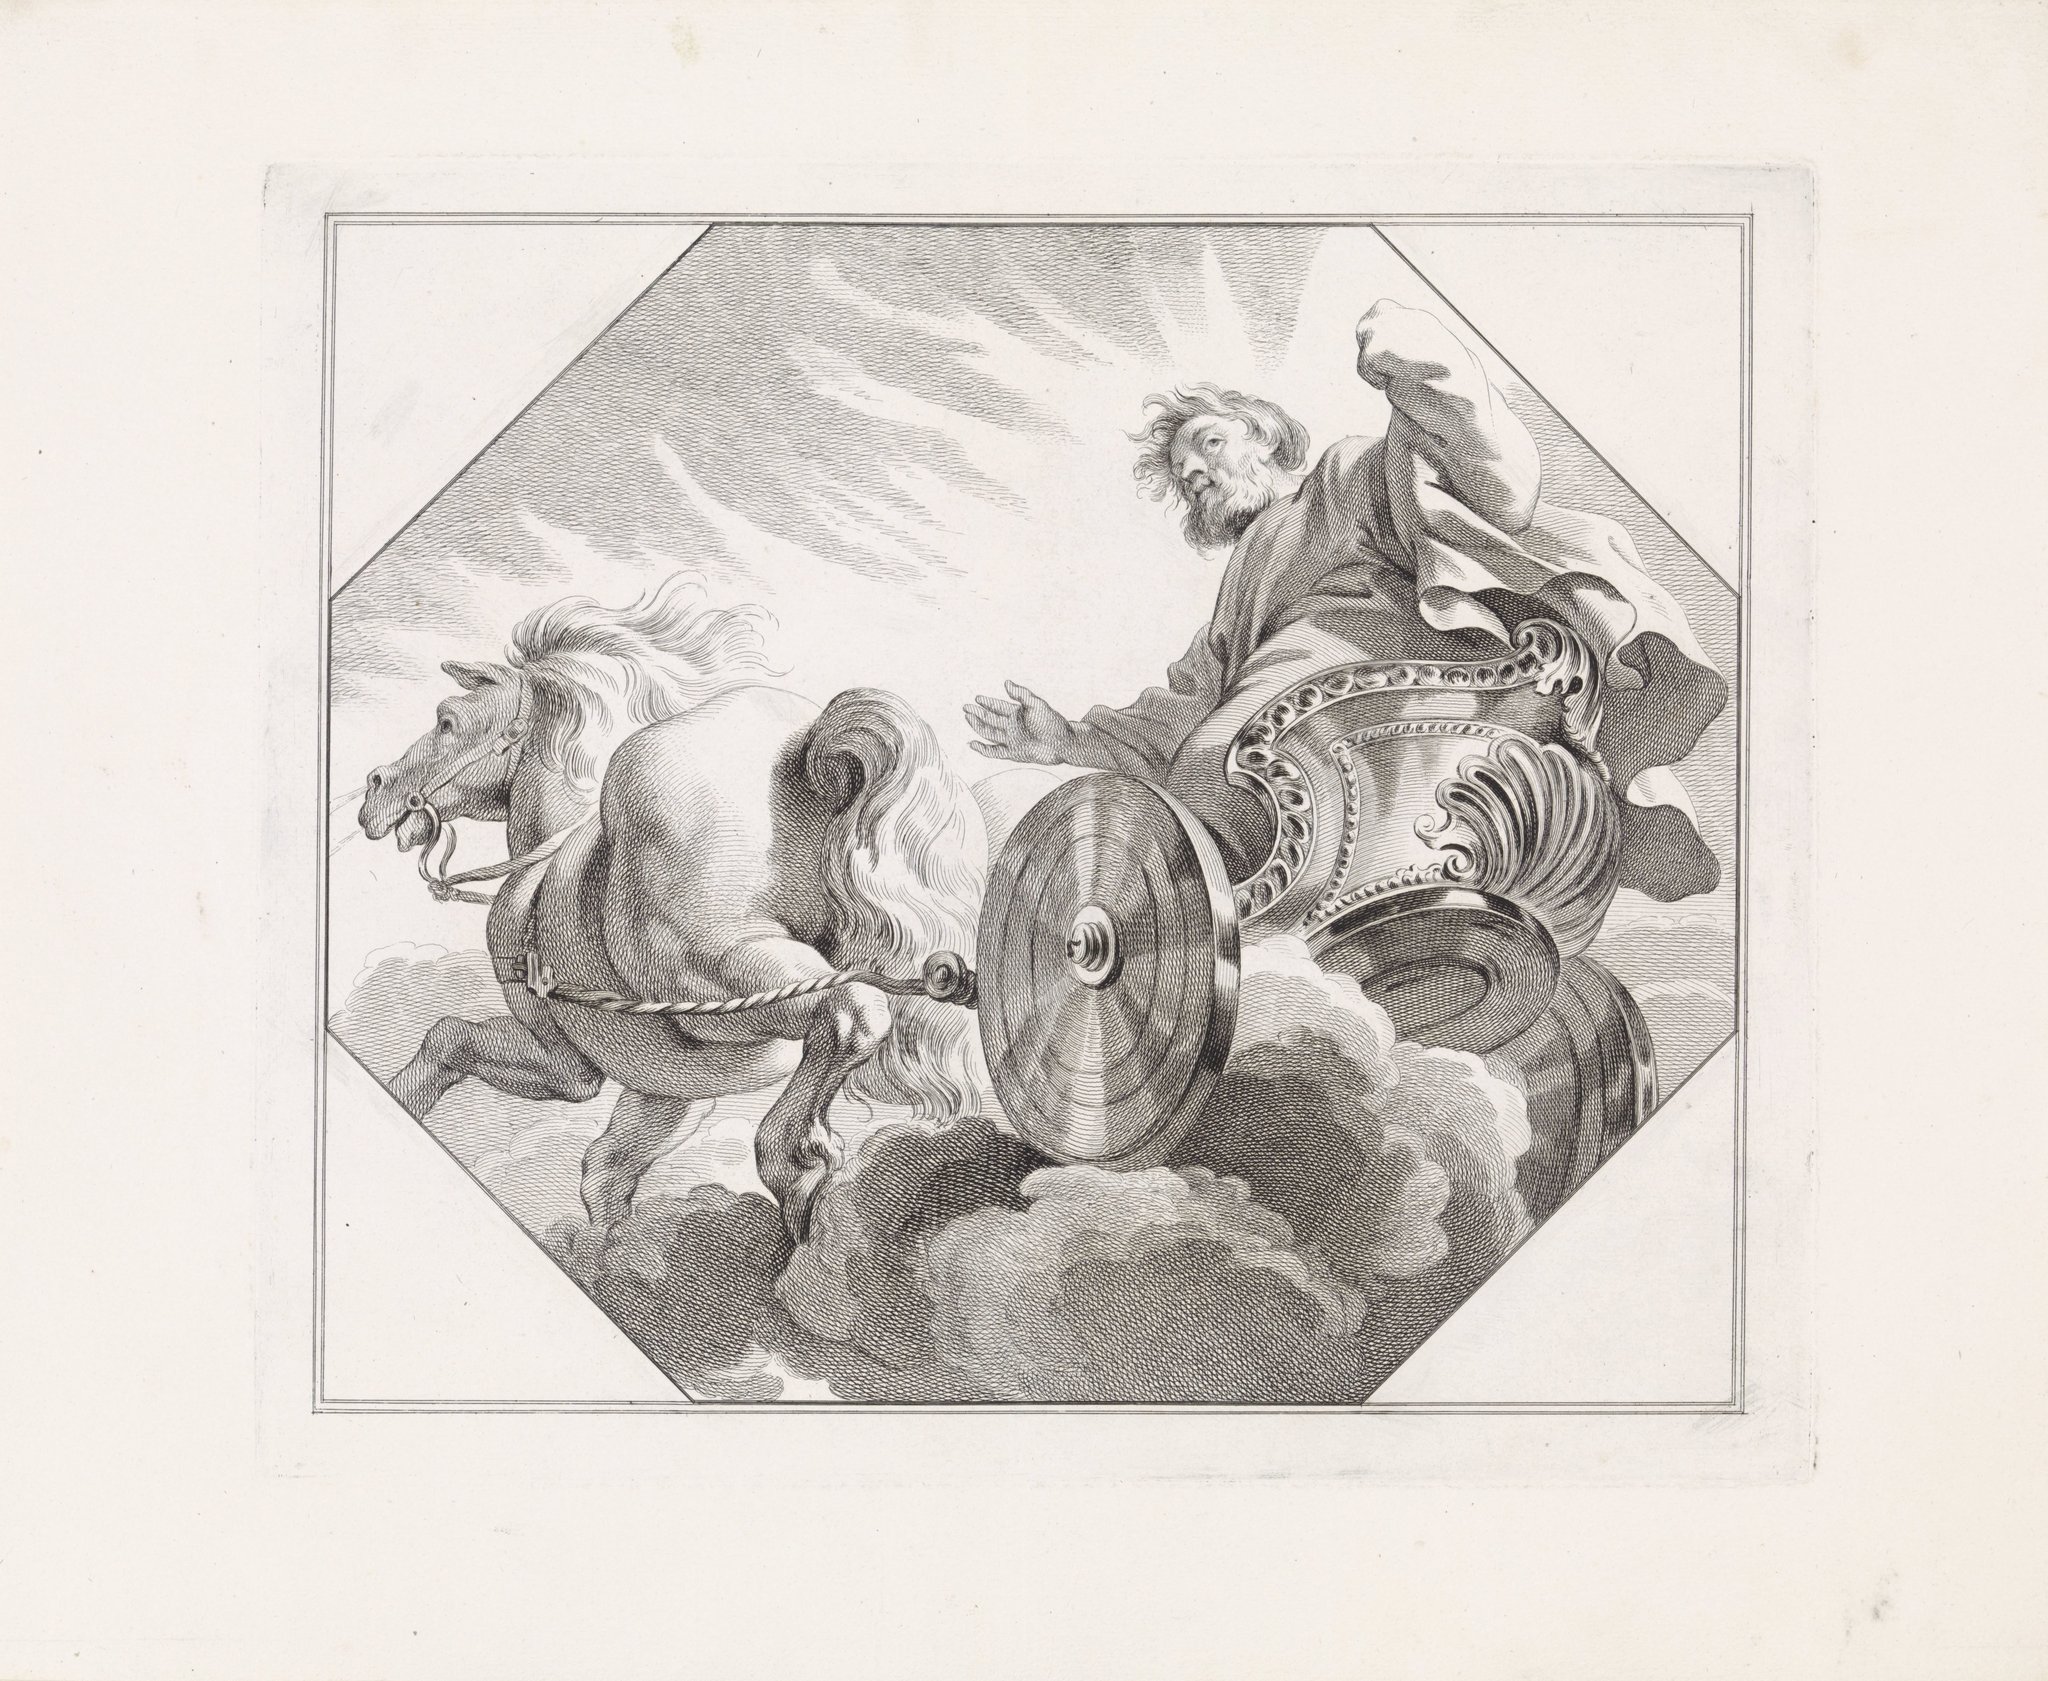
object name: print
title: Hemelvaart van Elia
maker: jan punt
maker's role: draughtsman, print maker, publisher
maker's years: 1711-1779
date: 1750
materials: paper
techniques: engraving, etching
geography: amsterdam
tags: a chariot, horses of fire and a whirlwind appear and elijah is carried up into heaven; elijah's cloak falls (or he hands it over to elisha)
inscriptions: collector's mark: Lugt 240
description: Elia in een wagen getrokken door een paard in de wolken.